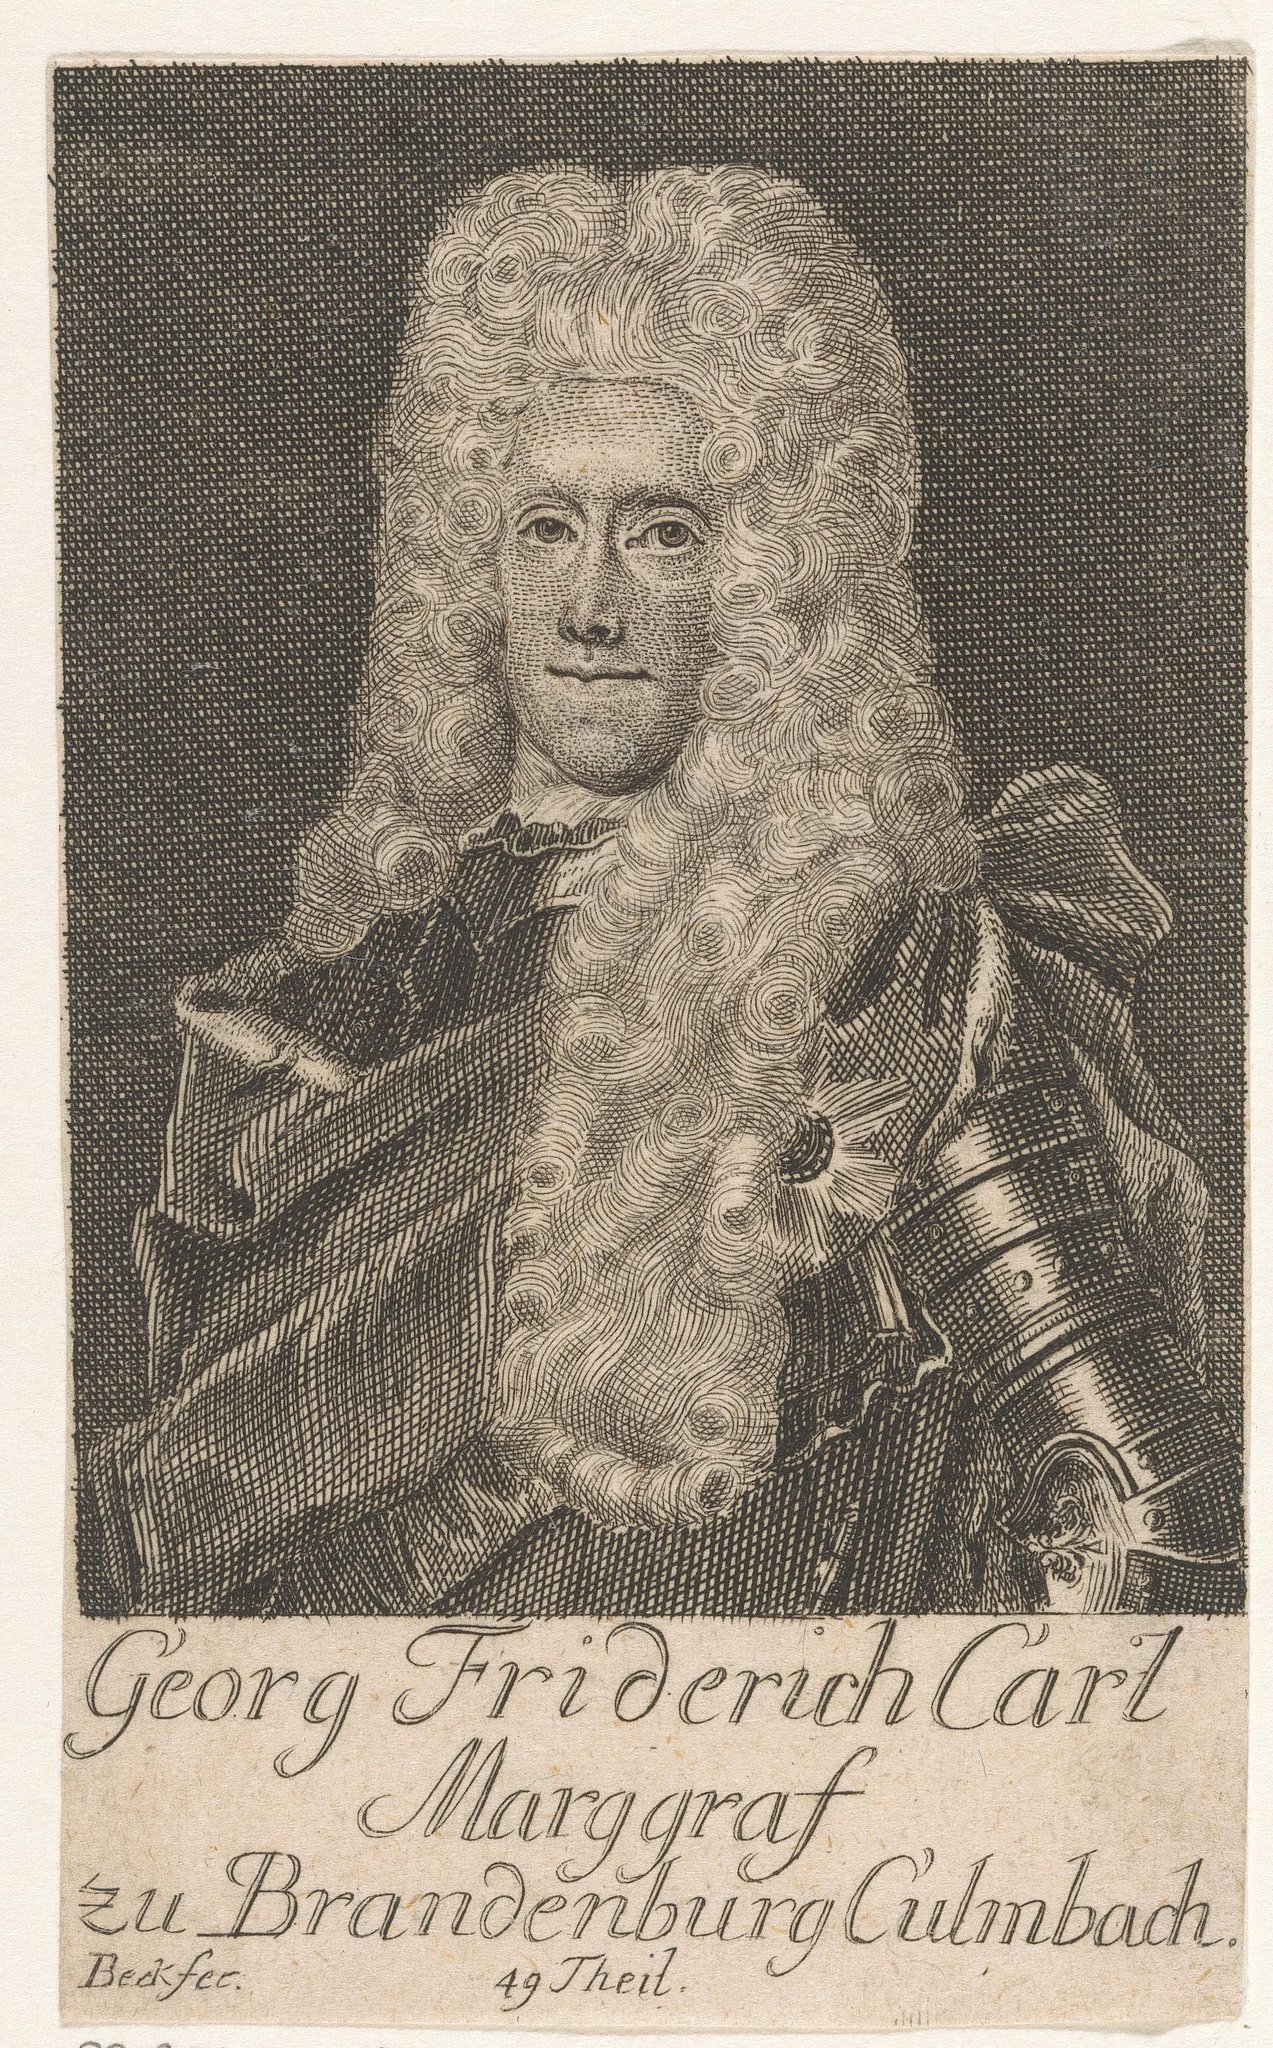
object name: print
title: Portret van George Friedrich Karl van Brandenburg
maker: tobias gabriel beck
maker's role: print maker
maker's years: 1685-1755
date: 1727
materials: paper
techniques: engraving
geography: nuremberg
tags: historical persons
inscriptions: collector's mark: Lugt 2228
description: Waarschijnlijk afkomstig uit: Europäische Staats-Cantzley, dl. 49, 1727.